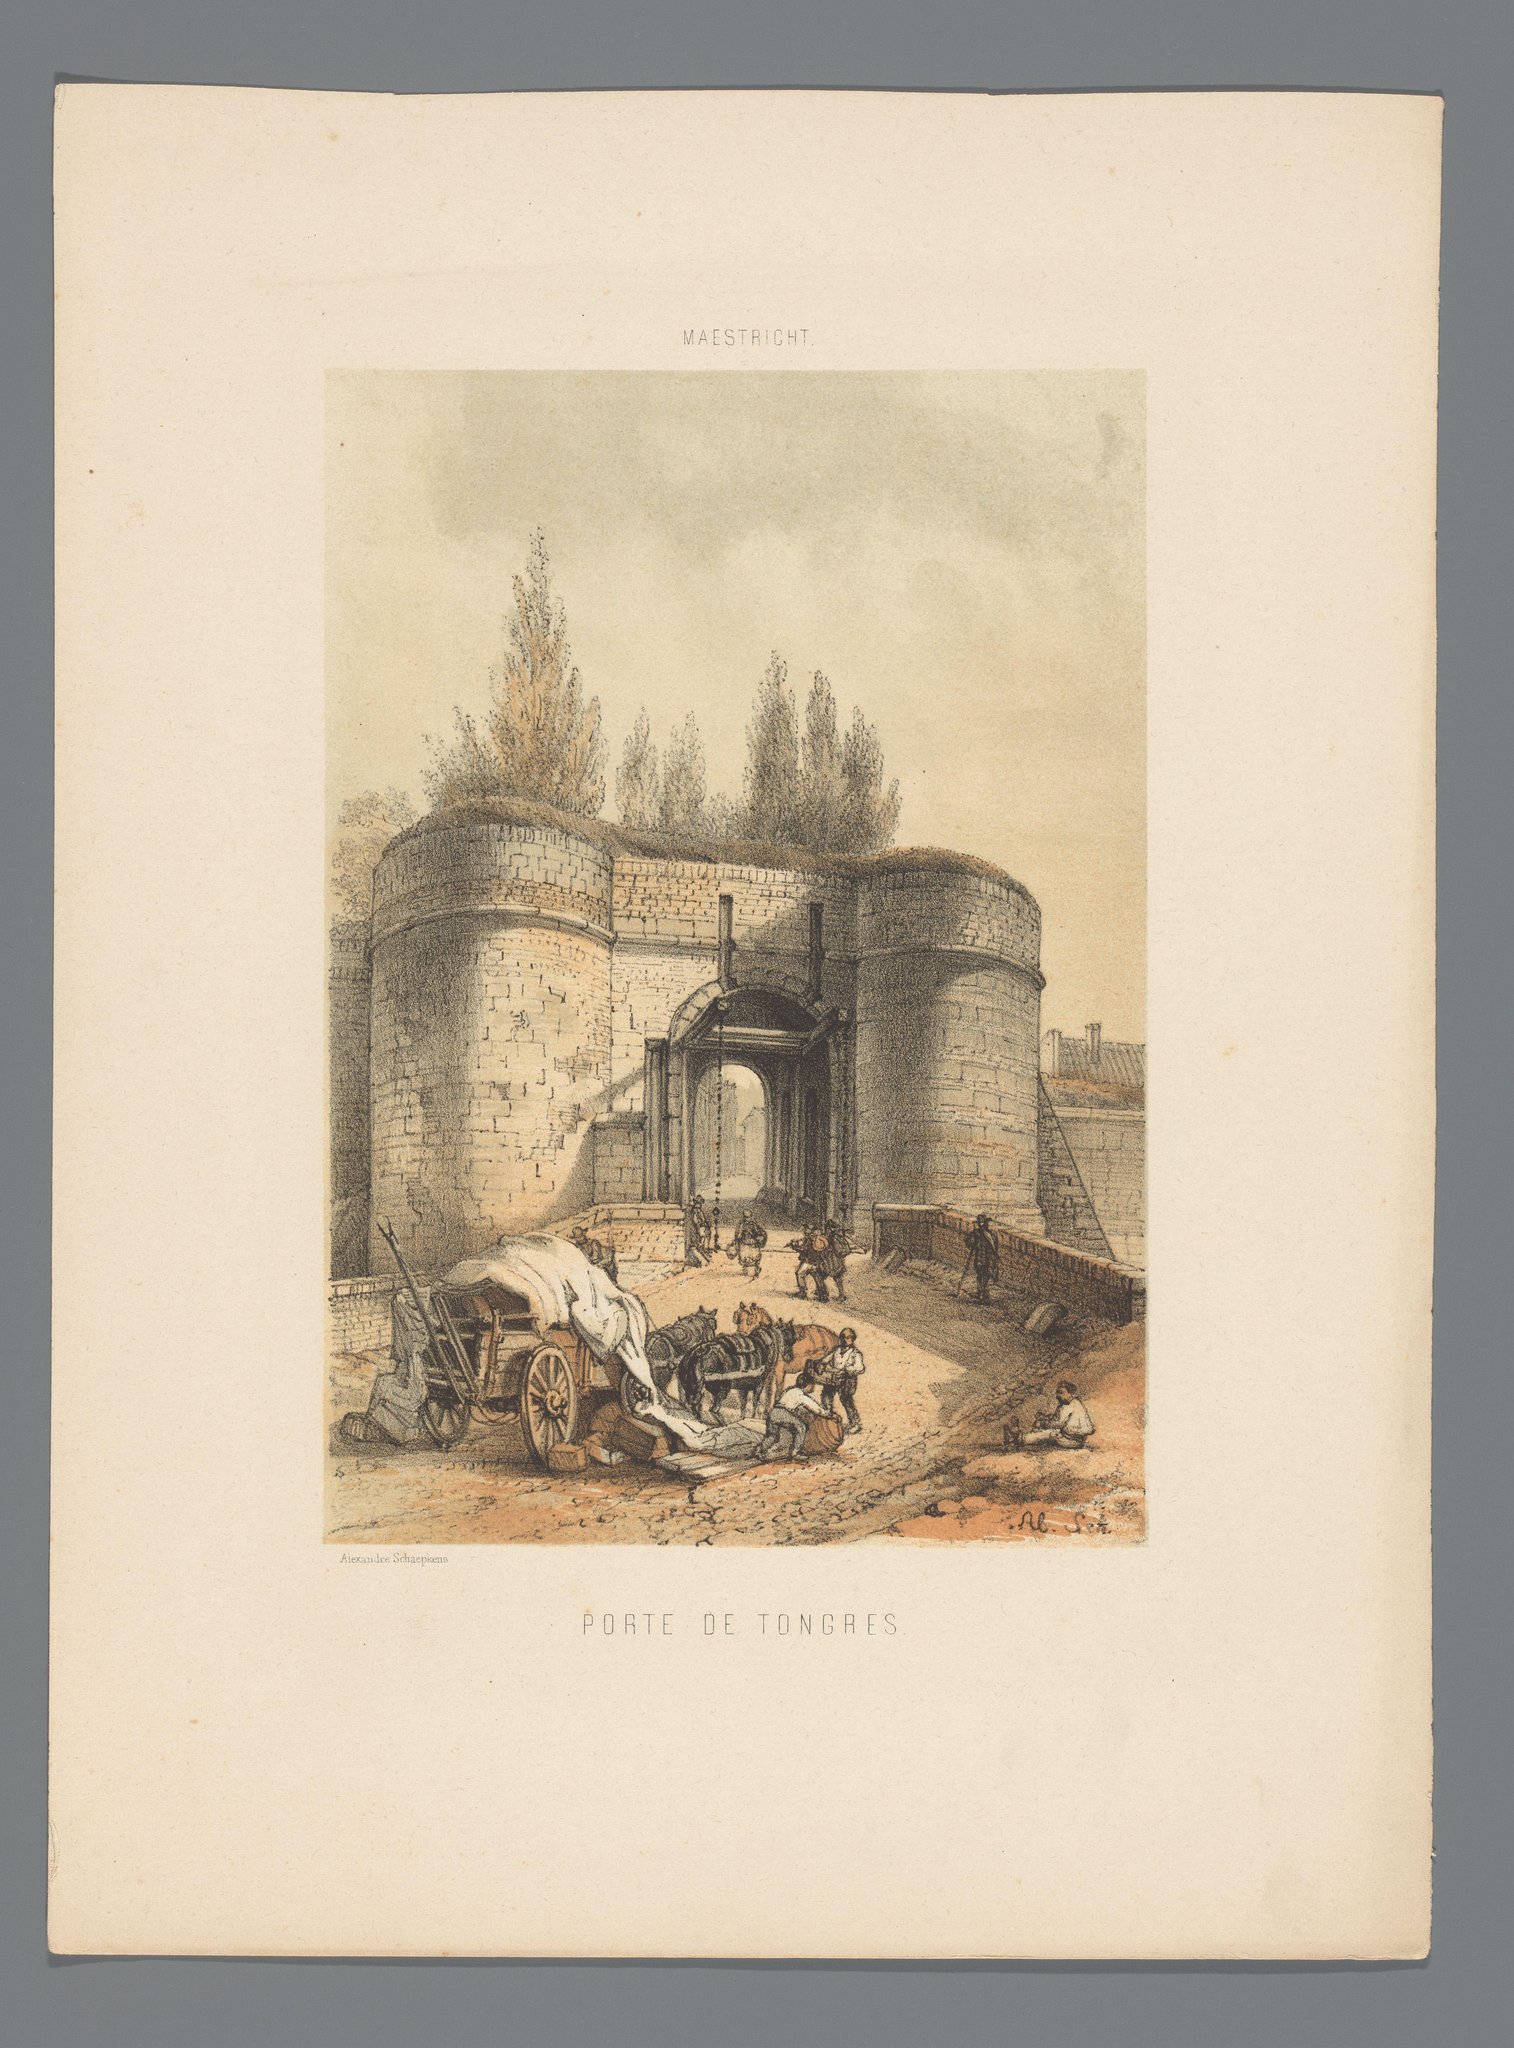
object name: print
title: Porte de Tongres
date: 1857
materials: paper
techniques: tone lithography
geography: brussels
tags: city-gate, maastricht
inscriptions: collector's mark: Lugt 2228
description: Veldzijde van de Tongersepoort. Op brug lopen figuren en paarden met wagen. Onderdeel van een omslag met een serie van tien lithografieën van monumenten te Maastricht.